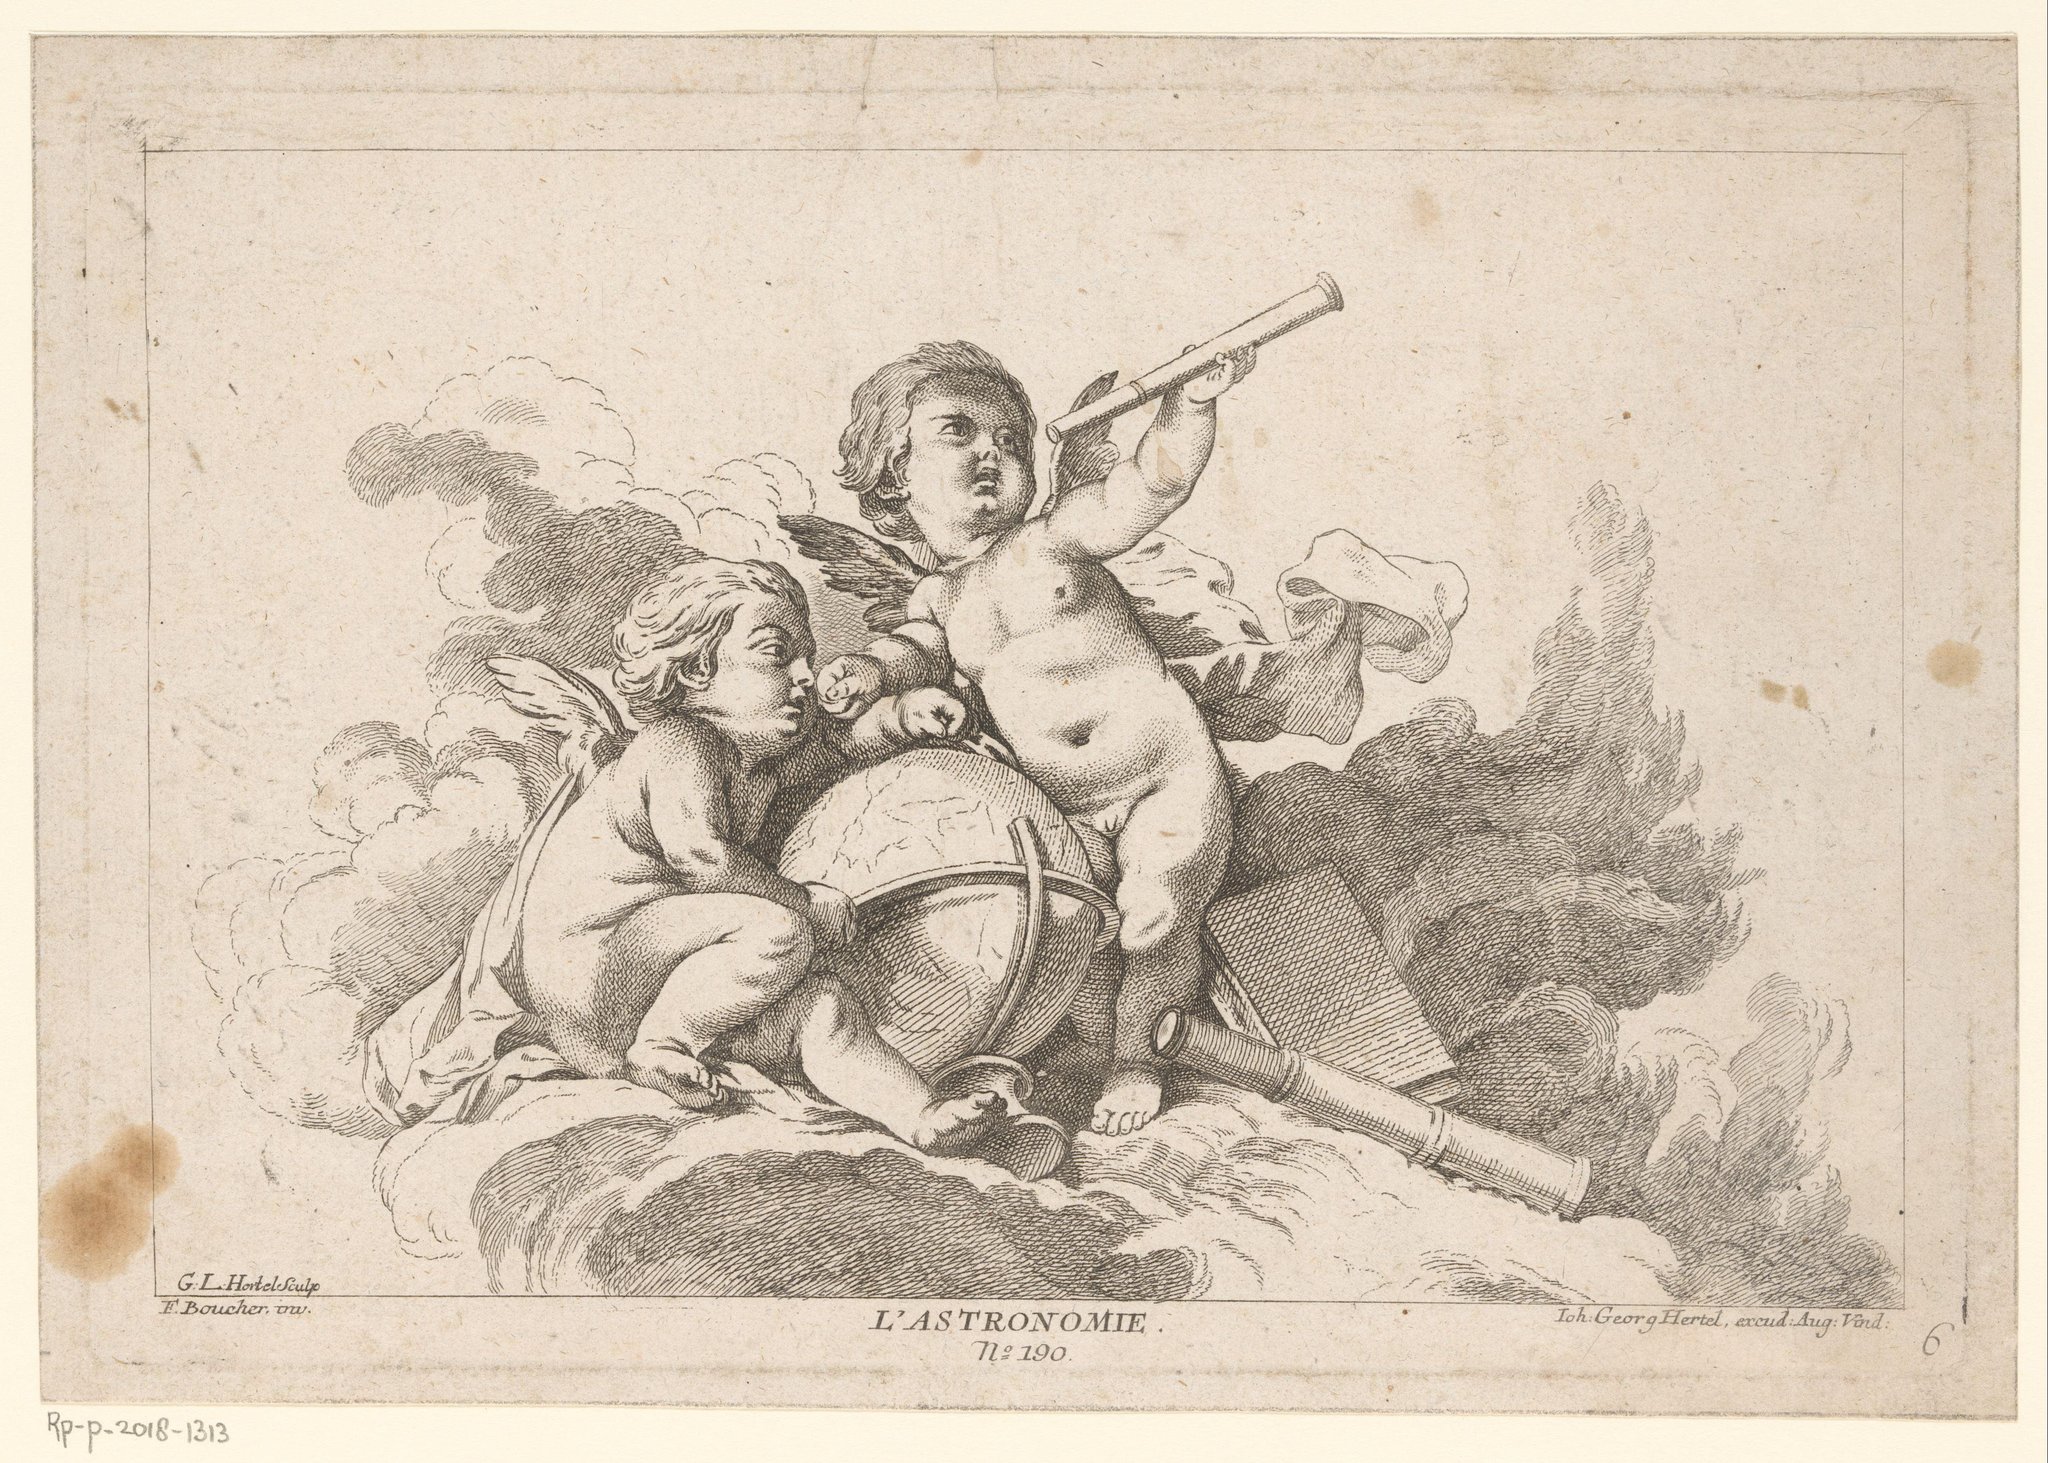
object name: ornament print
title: Livre des Arts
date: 1750-1778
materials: paper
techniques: engraving, etching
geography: augsburg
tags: 'astronomia', 'cosmografia'; 'cosmografia' (ripa), globe, cupids: 'amores', 'amoretti', 'putti'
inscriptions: collector's mark: Lugt 2228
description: Allegorie van de astronomie. Twee putti met telescopen en een globe. Uitgeversnummer 190.